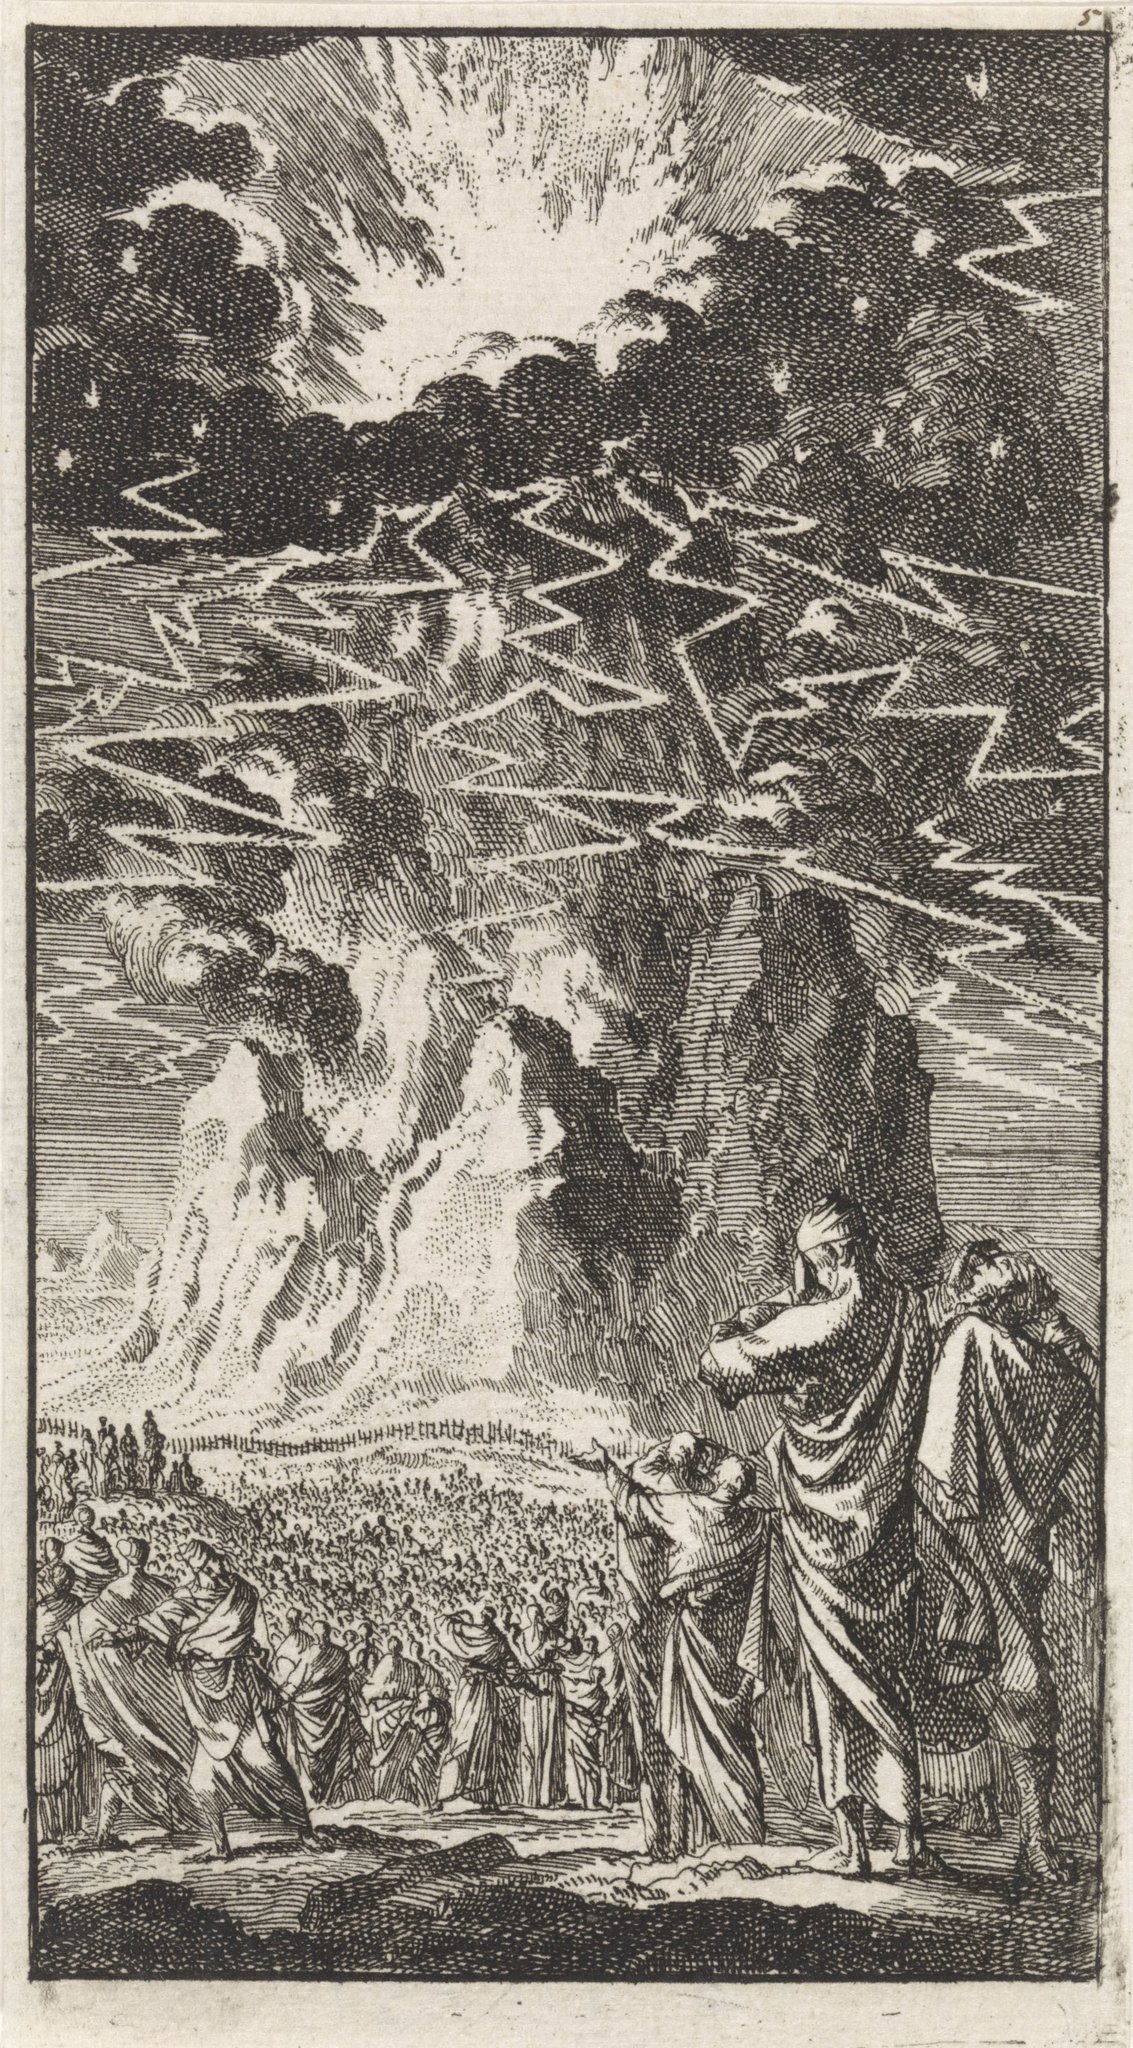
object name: print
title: Wetgeving op de berg Sinaï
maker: jan luyken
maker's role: draughtsman, print maker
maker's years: 1649-1712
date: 1712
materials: paper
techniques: etching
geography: amsterdam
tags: mount sinai is covered by a thick cloud, thunder and lightning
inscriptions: collector's mark: Lugt 2228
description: Proefdruk van illustratie voor: Luyken, Jan. Bybel printen. Amsterdam: Pieter Arentsz. II (wed.) en Cornelis van der Sys, 1712, p. 6.